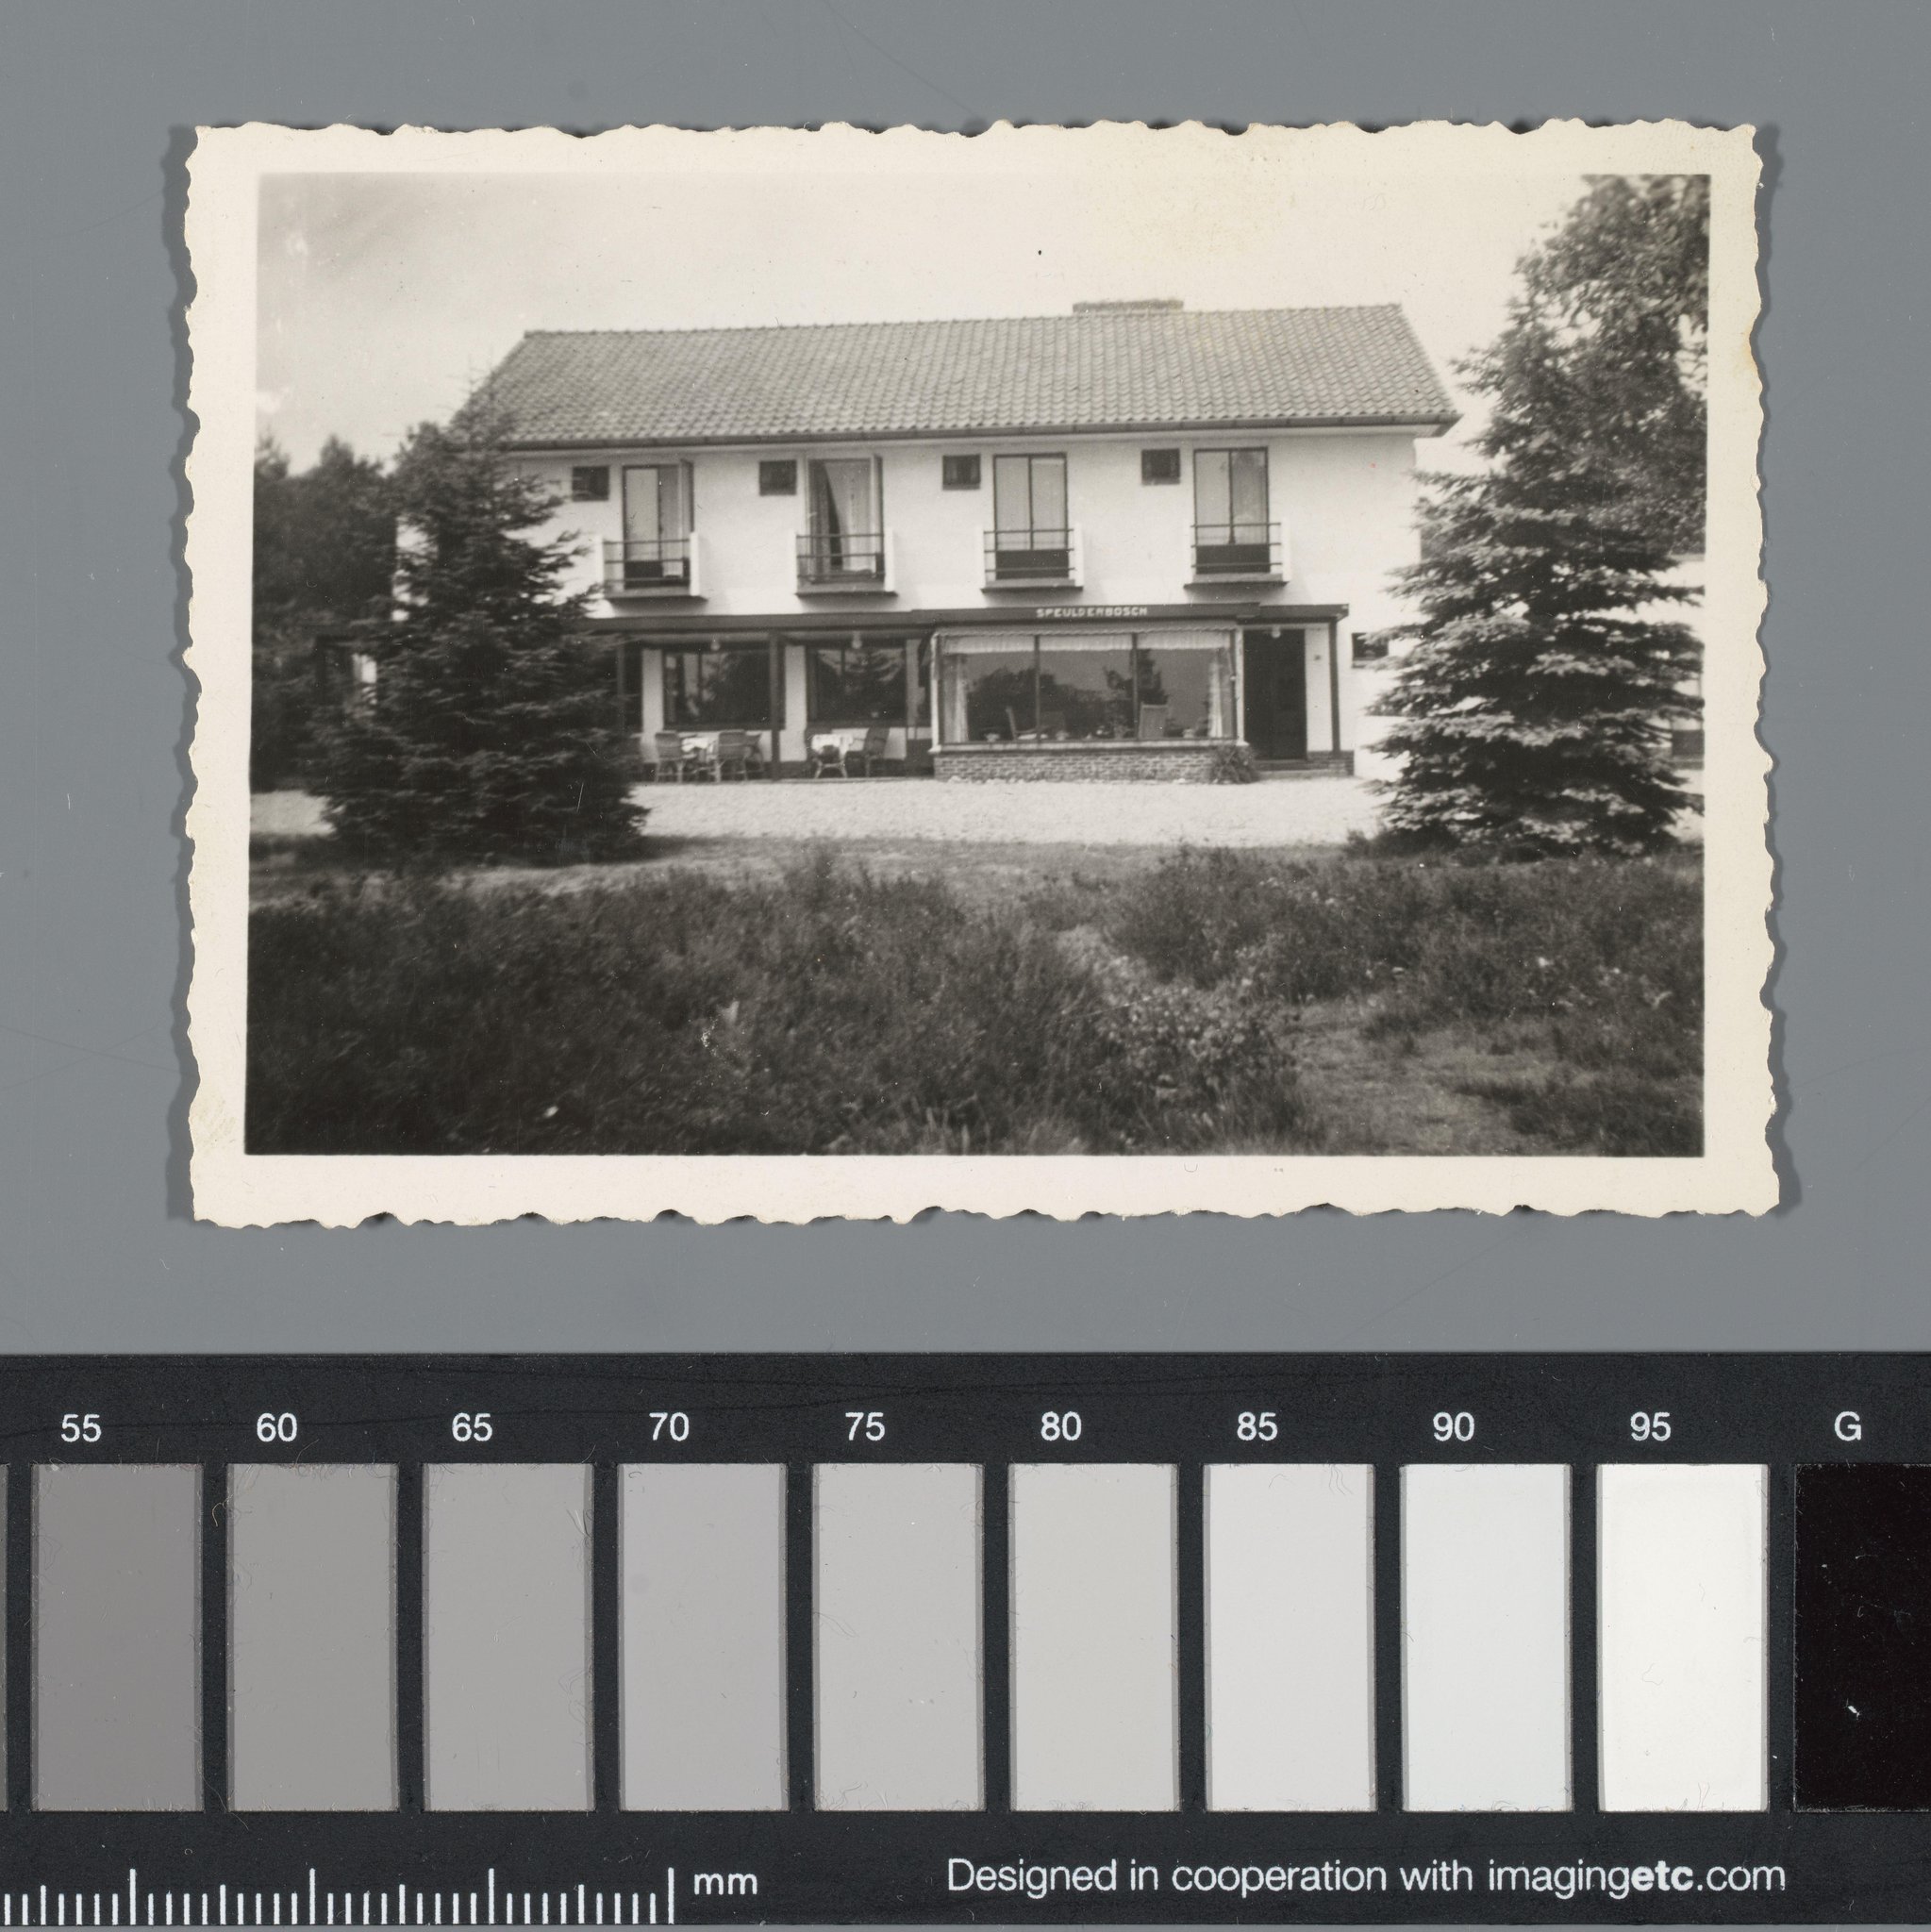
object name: photograph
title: Hotel Speulderbosch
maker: cornelia hendrika jonker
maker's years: 1874-1924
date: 1910-1950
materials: photographic support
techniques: gelatin silver print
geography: garderen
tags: façade (of house or building), hotel, hostelry, inn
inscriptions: number: ‘H835’